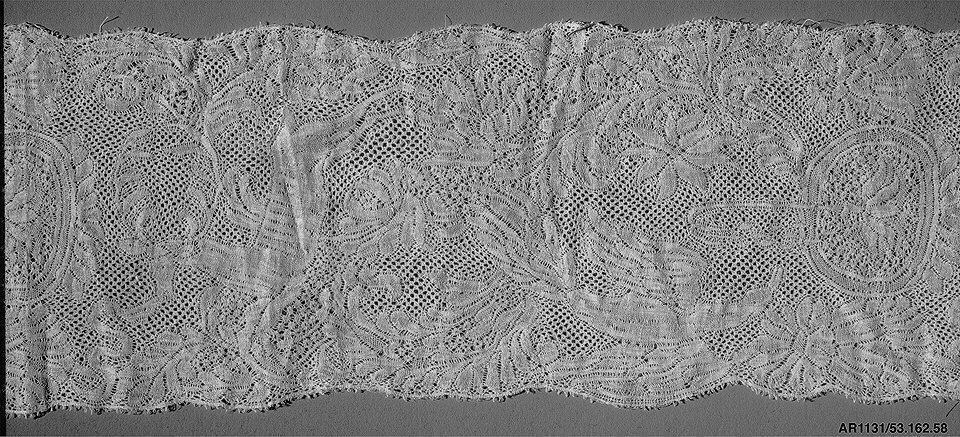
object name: lappet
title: Pair of lappets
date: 1701-1800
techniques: lace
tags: animals,birds,flowers